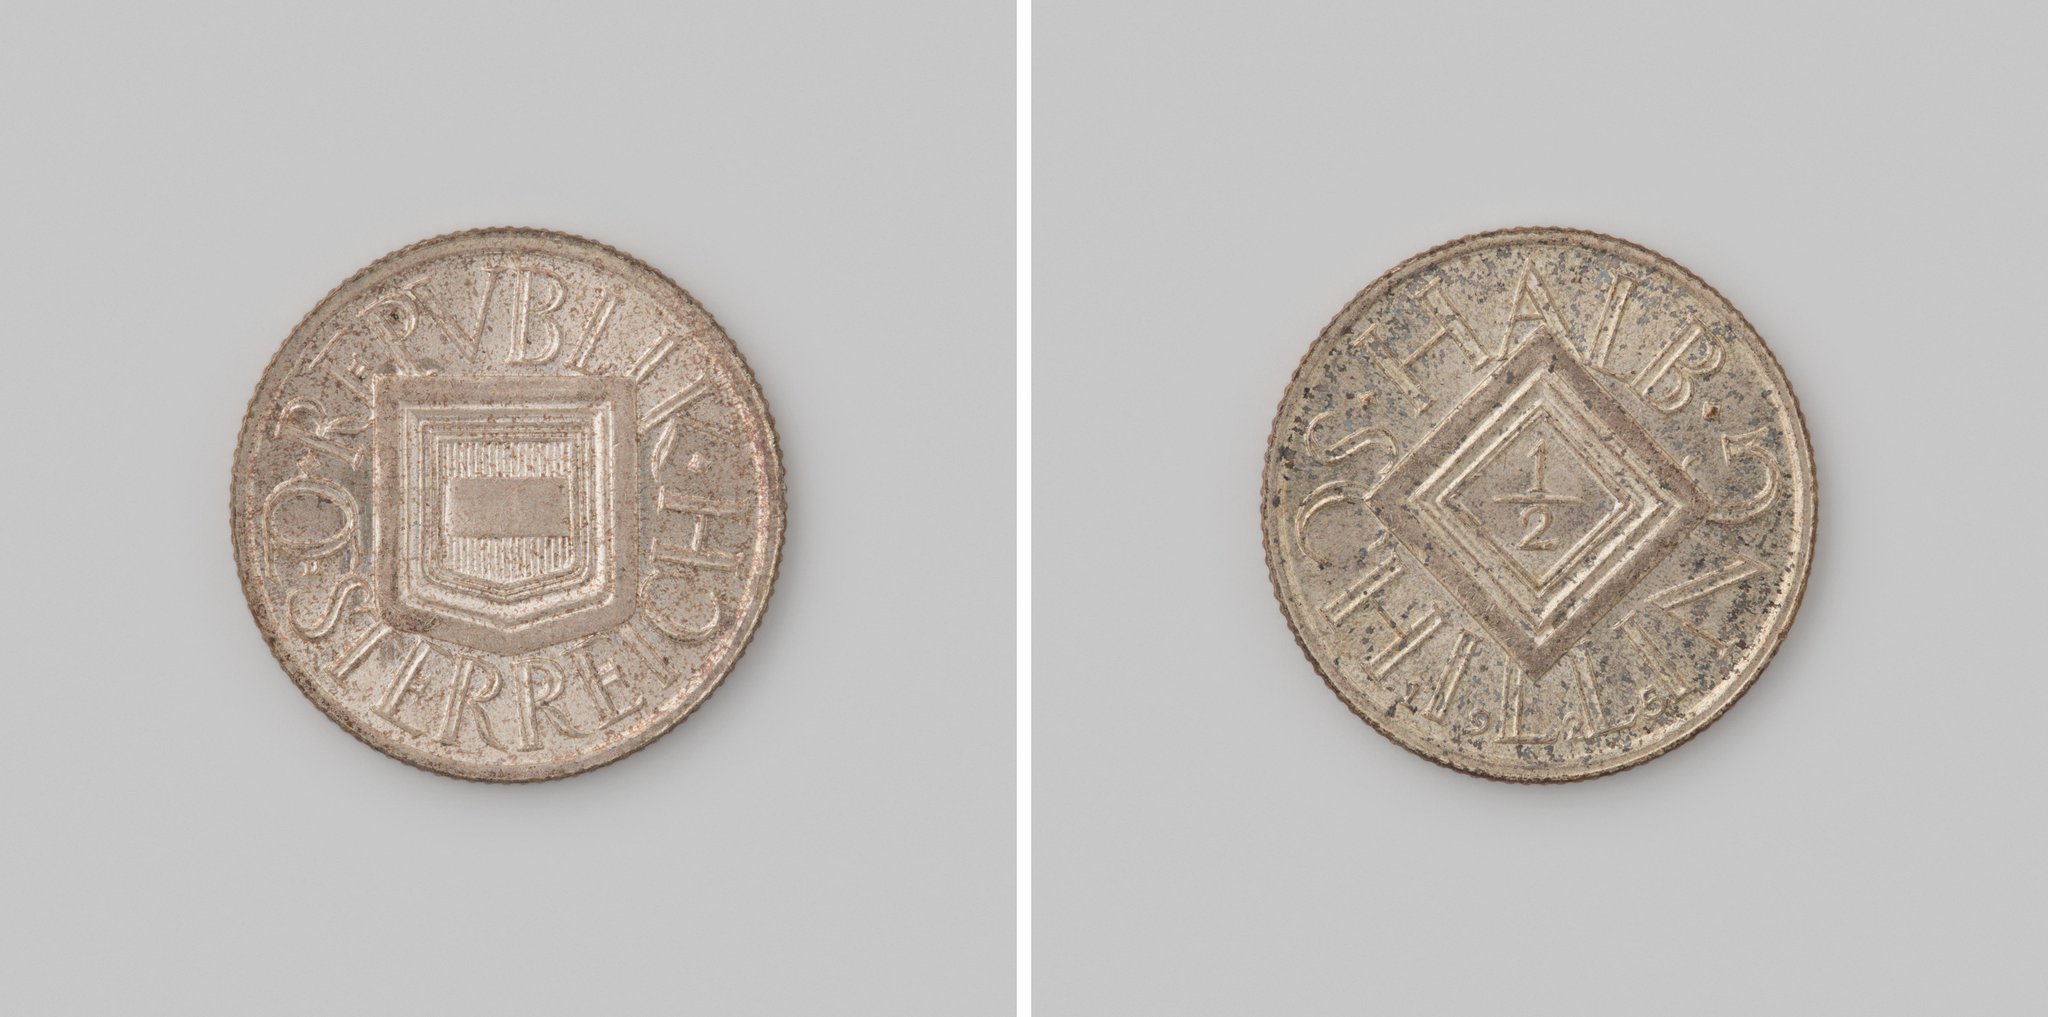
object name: coin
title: Republiek Oostenrijk, ½ schilling,1925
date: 1925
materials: silver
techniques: striking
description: Zilveren munt. Voorzijde: wapenschild van Oostenrijk. Keerzijde: op takken wapenschild van Oostenrijk. Waarde-aanduiding in ruit en als omschrift. Jaartal onderaan in omschrift. Kartelrand.